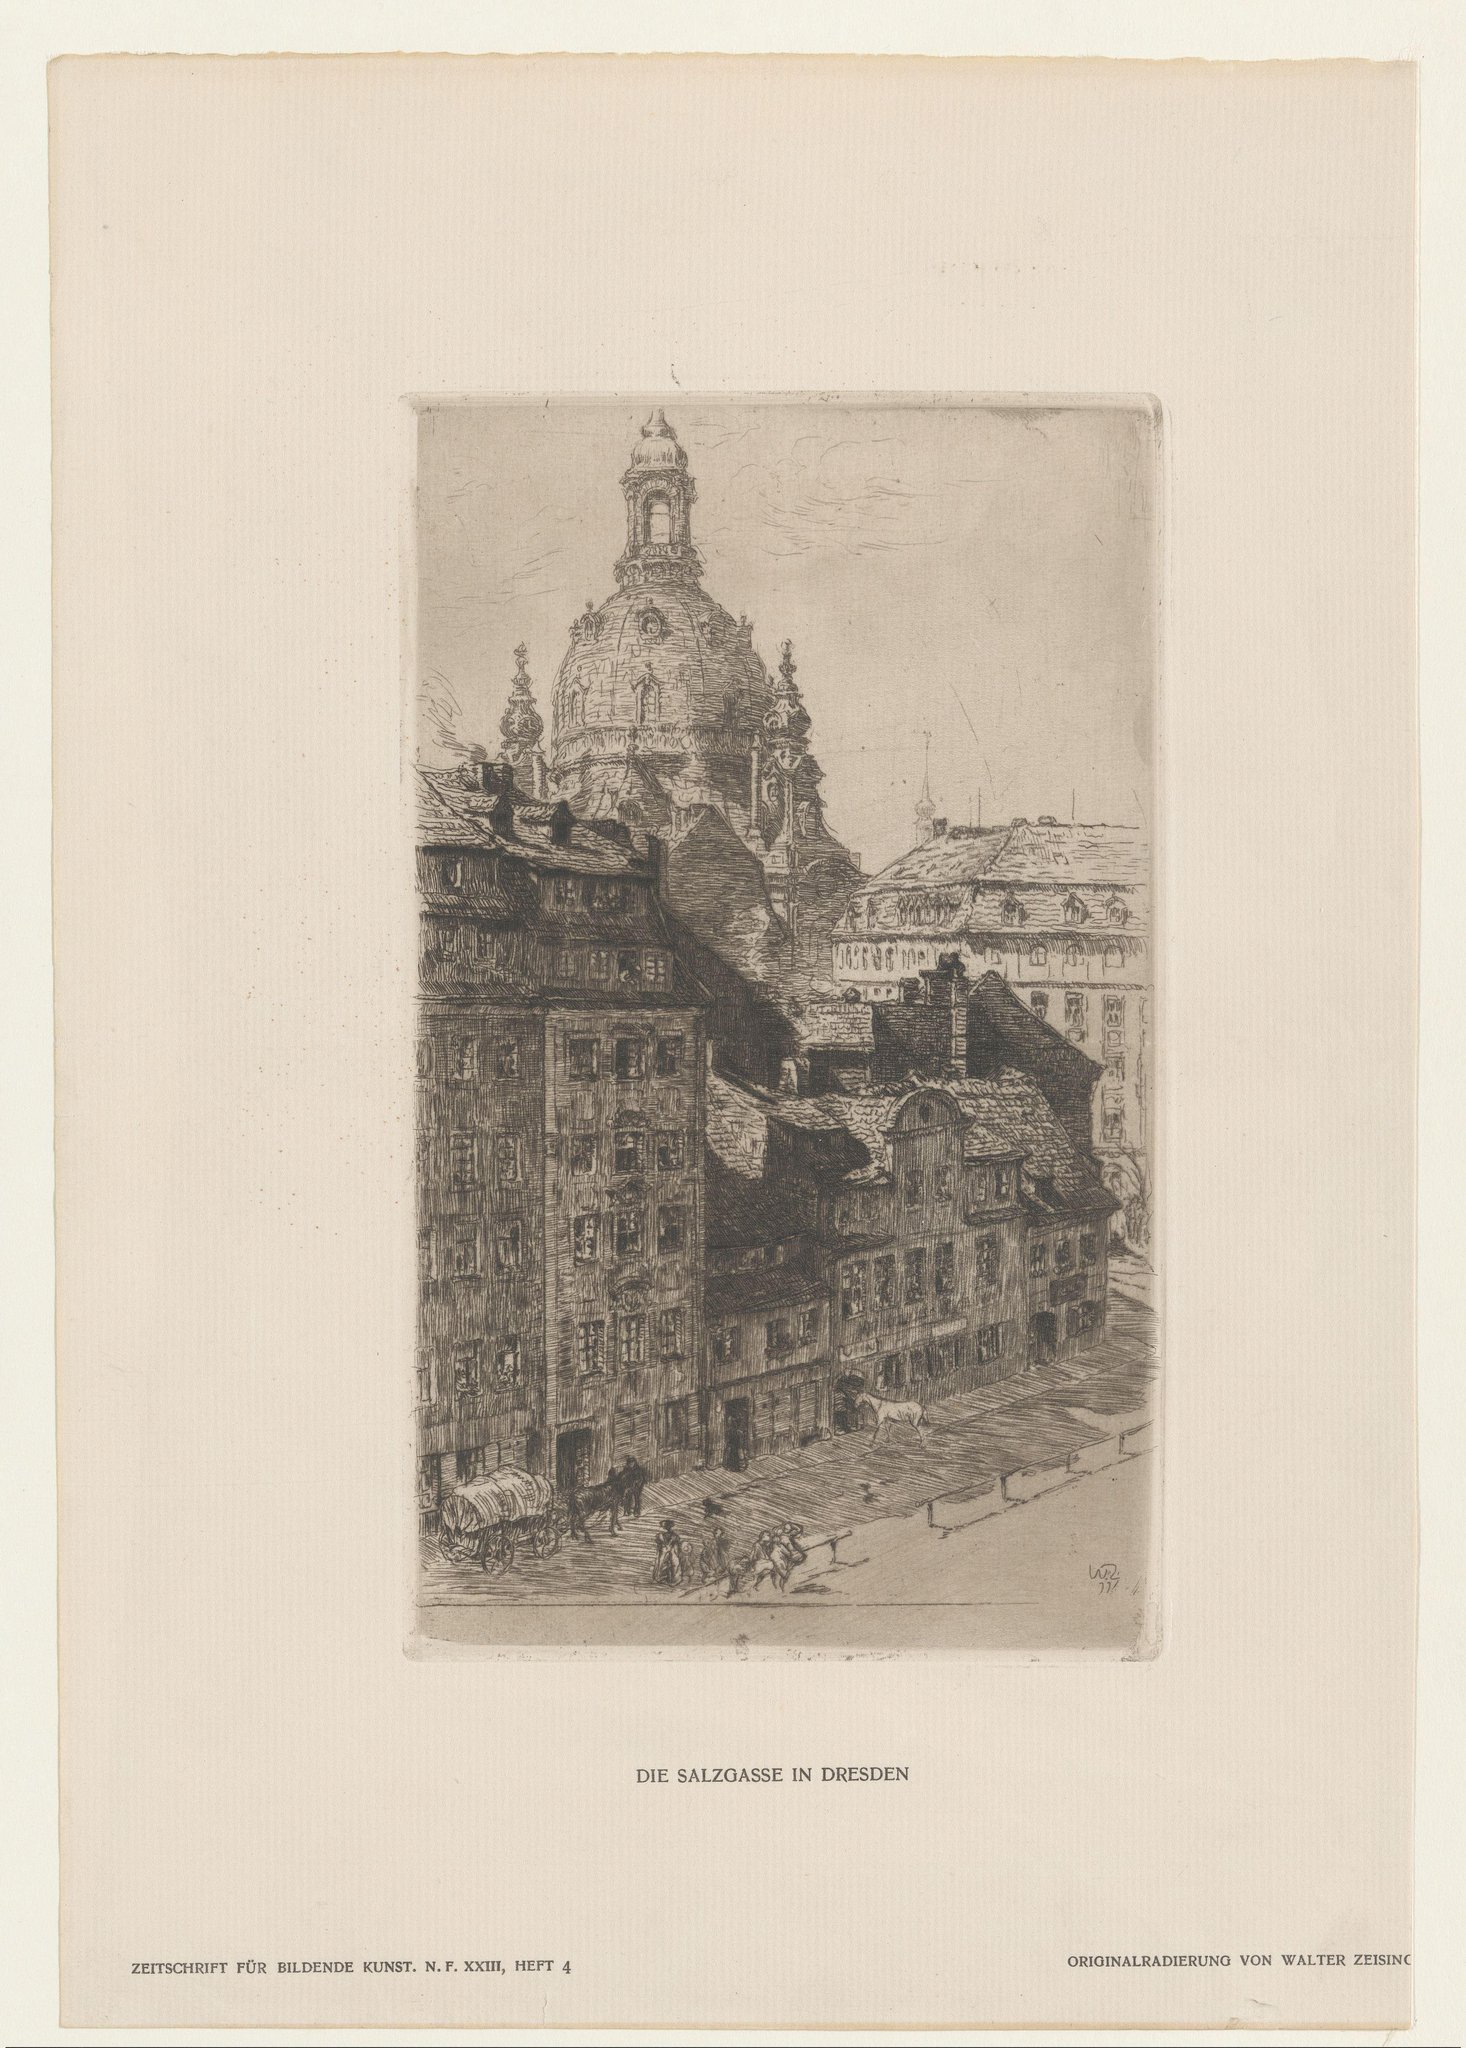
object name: print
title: Die Salzgasse in Dresden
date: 1912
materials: paper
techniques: etching, intaglio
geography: leipzig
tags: church (exterior), prospect of city, town panorama, silhouette of city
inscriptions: collector's mark: Lugt 2228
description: Linksonder gemerkt: Zeitschrift für Bildende Kunst. N.F. XXIII, Heft 4.